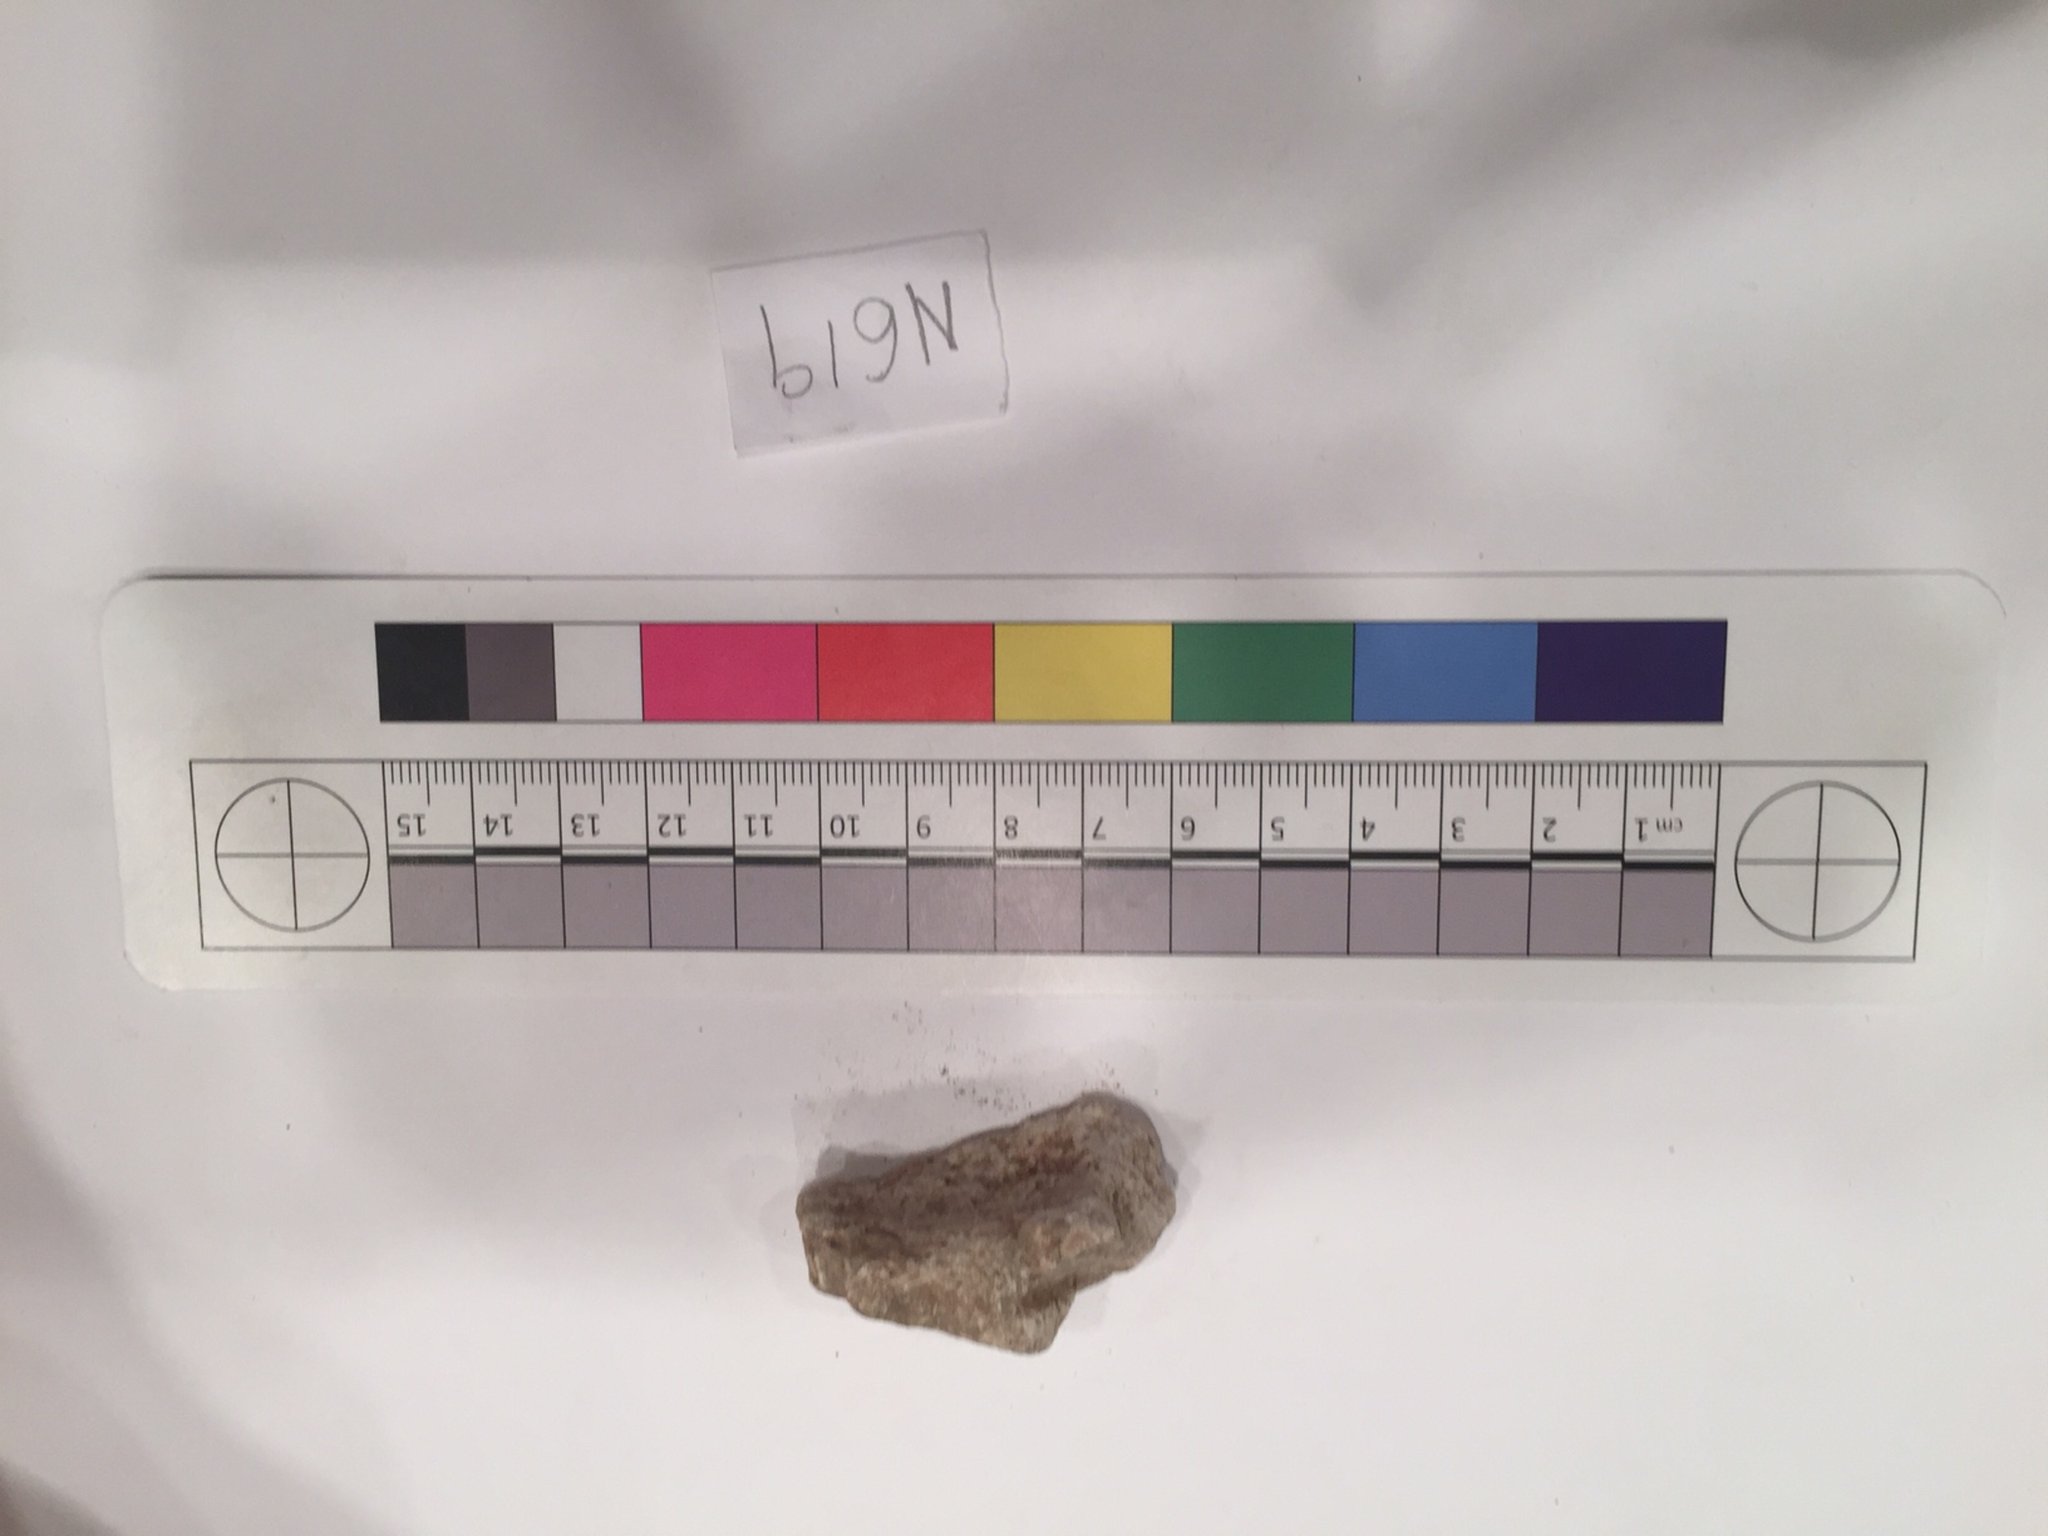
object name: fragment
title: Stucco Fragment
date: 701-1200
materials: plaster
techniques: carving, painting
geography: iran